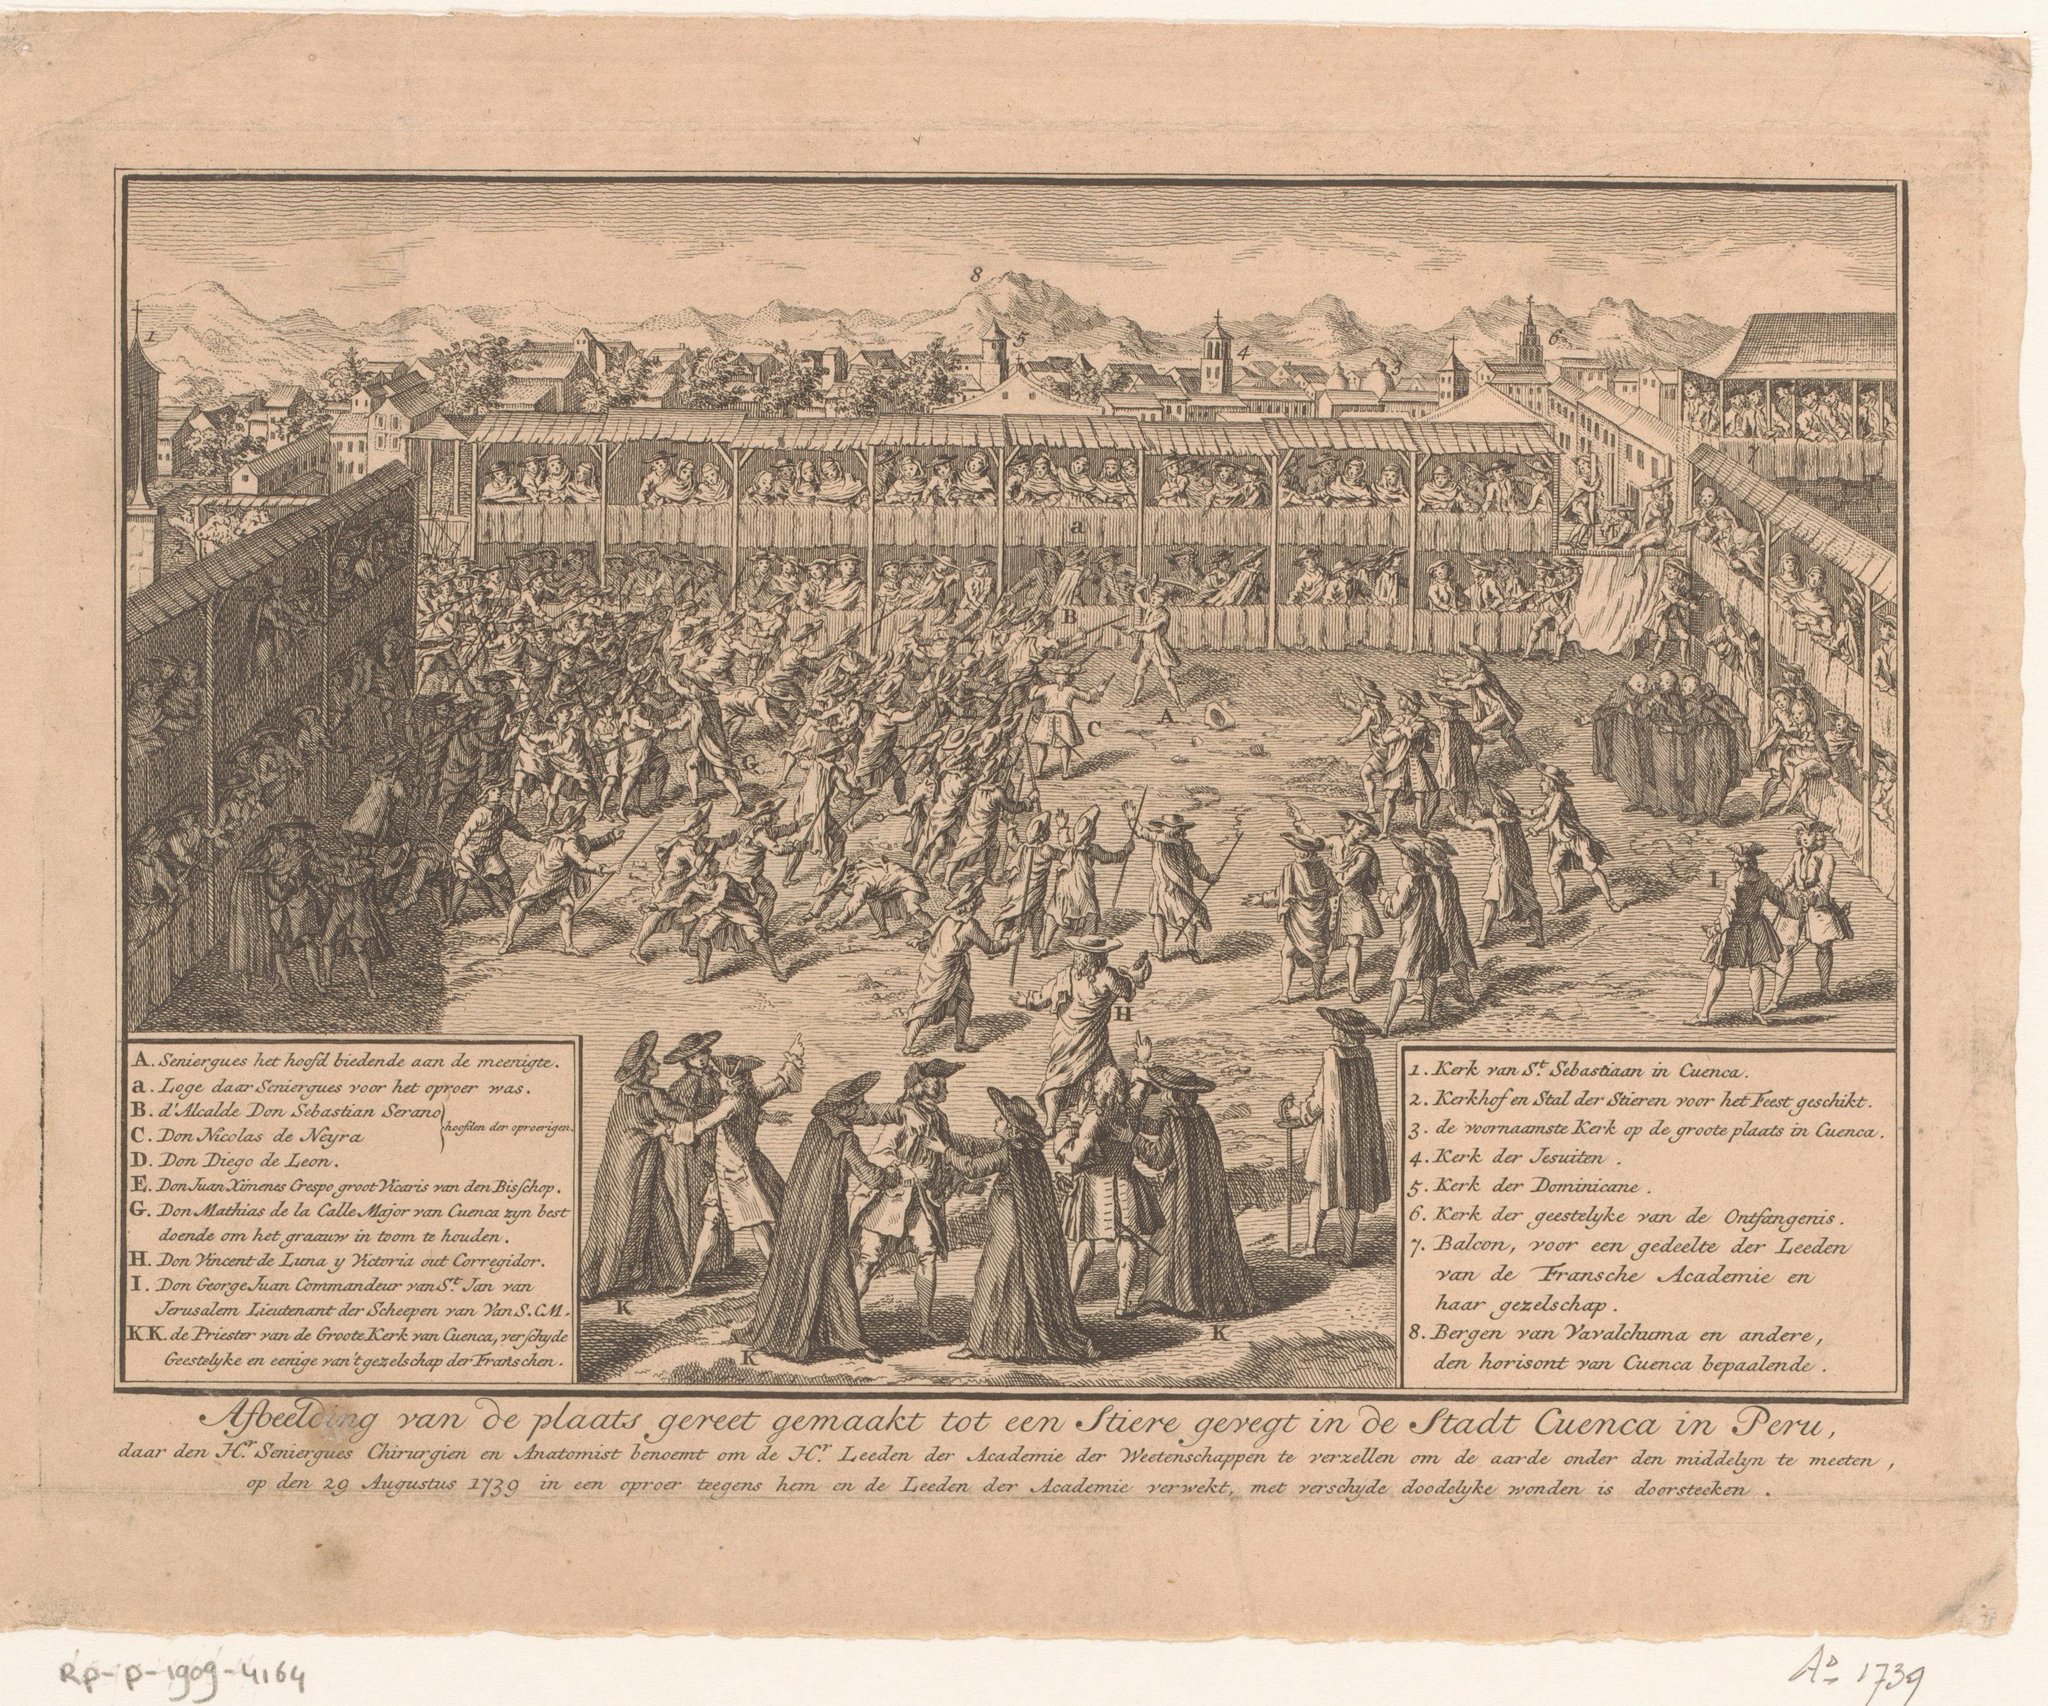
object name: print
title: Gereed maken van de arena in Cuenca voor het stierengevecht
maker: Anonymous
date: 1739-1780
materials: paper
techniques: etching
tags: fighting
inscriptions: collector's mark: Lugt 2228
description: Grote massa mensen in de arena in Cuenca in Peru. De heer Seniergues en leden van de academie meten de aarde onder de middenlijn op 29 augustus 1739. In een oproer tegen hen is Seniergues dood gestoken. Links en rechts een legenda met persoons- en plaatsaanduidingen.